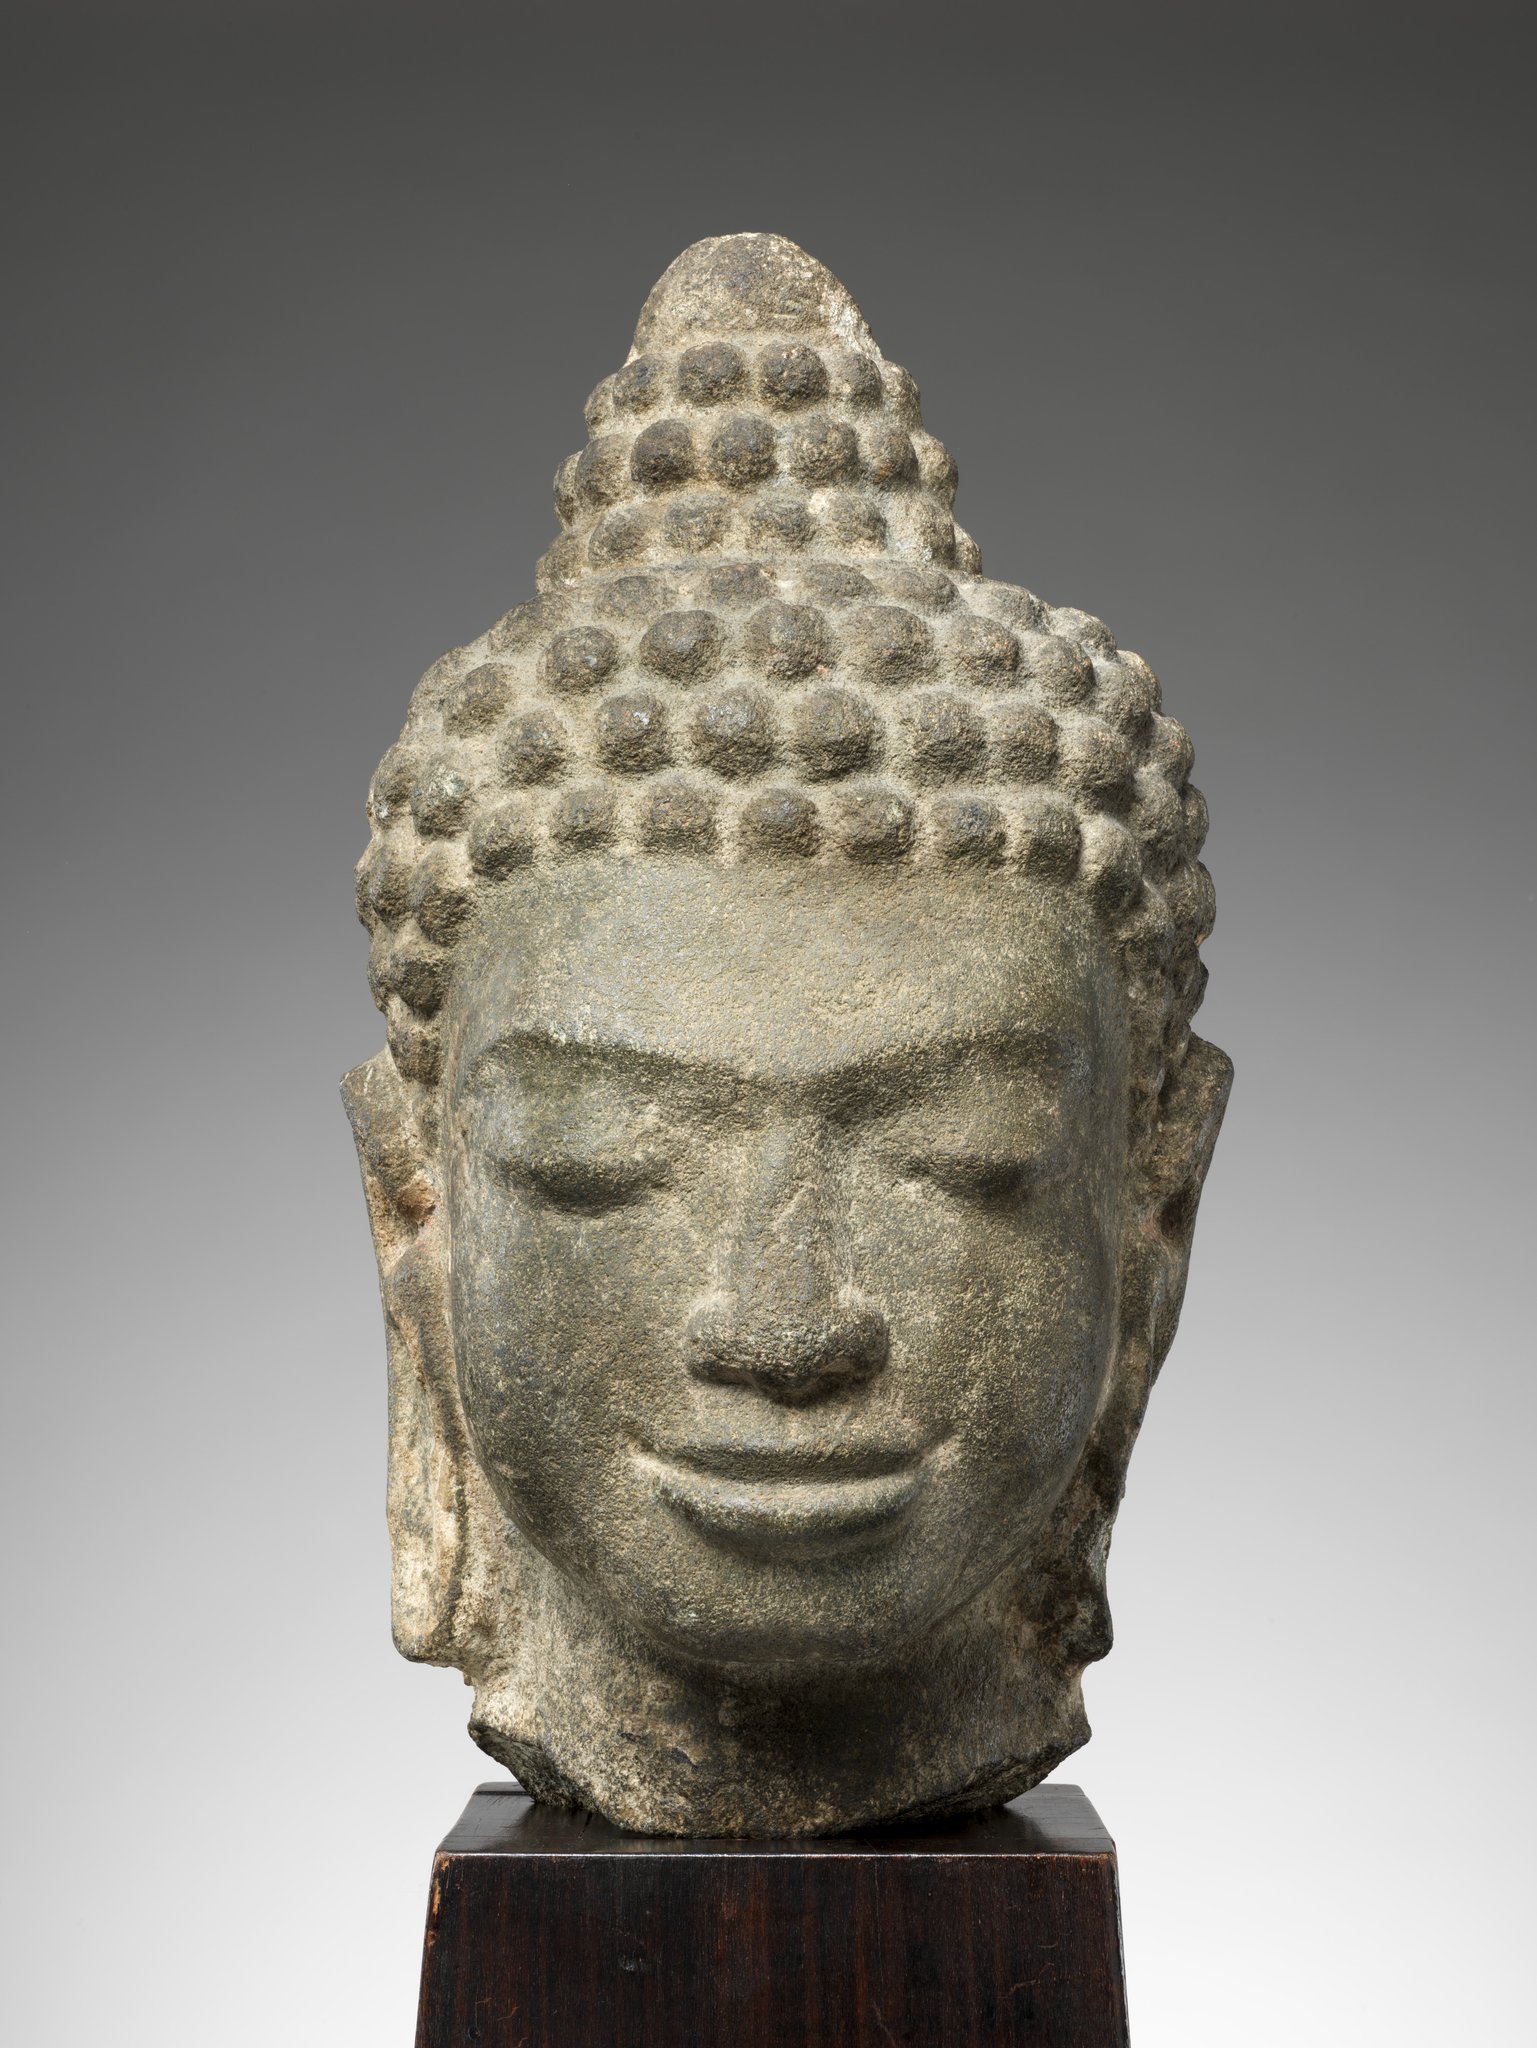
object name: head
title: Head of the Buddha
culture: thai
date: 601-800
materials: stone